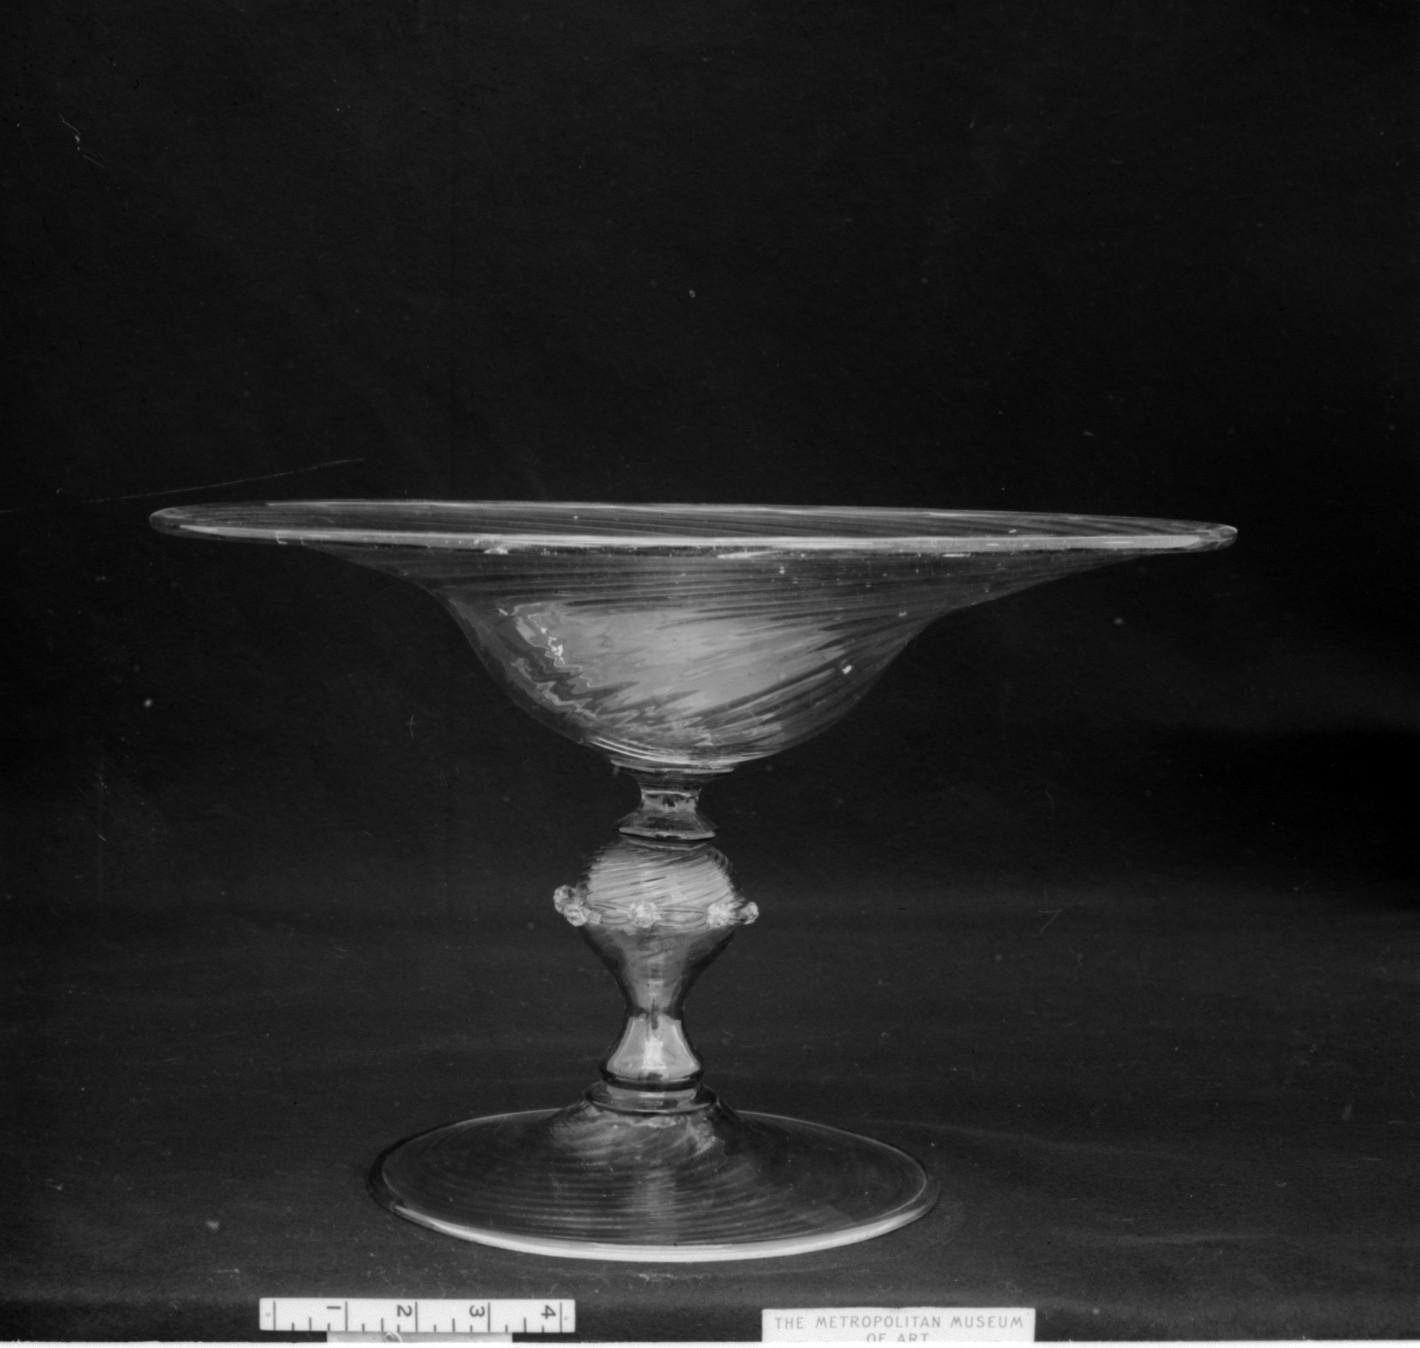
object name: tazza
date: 1801-1900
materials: glass